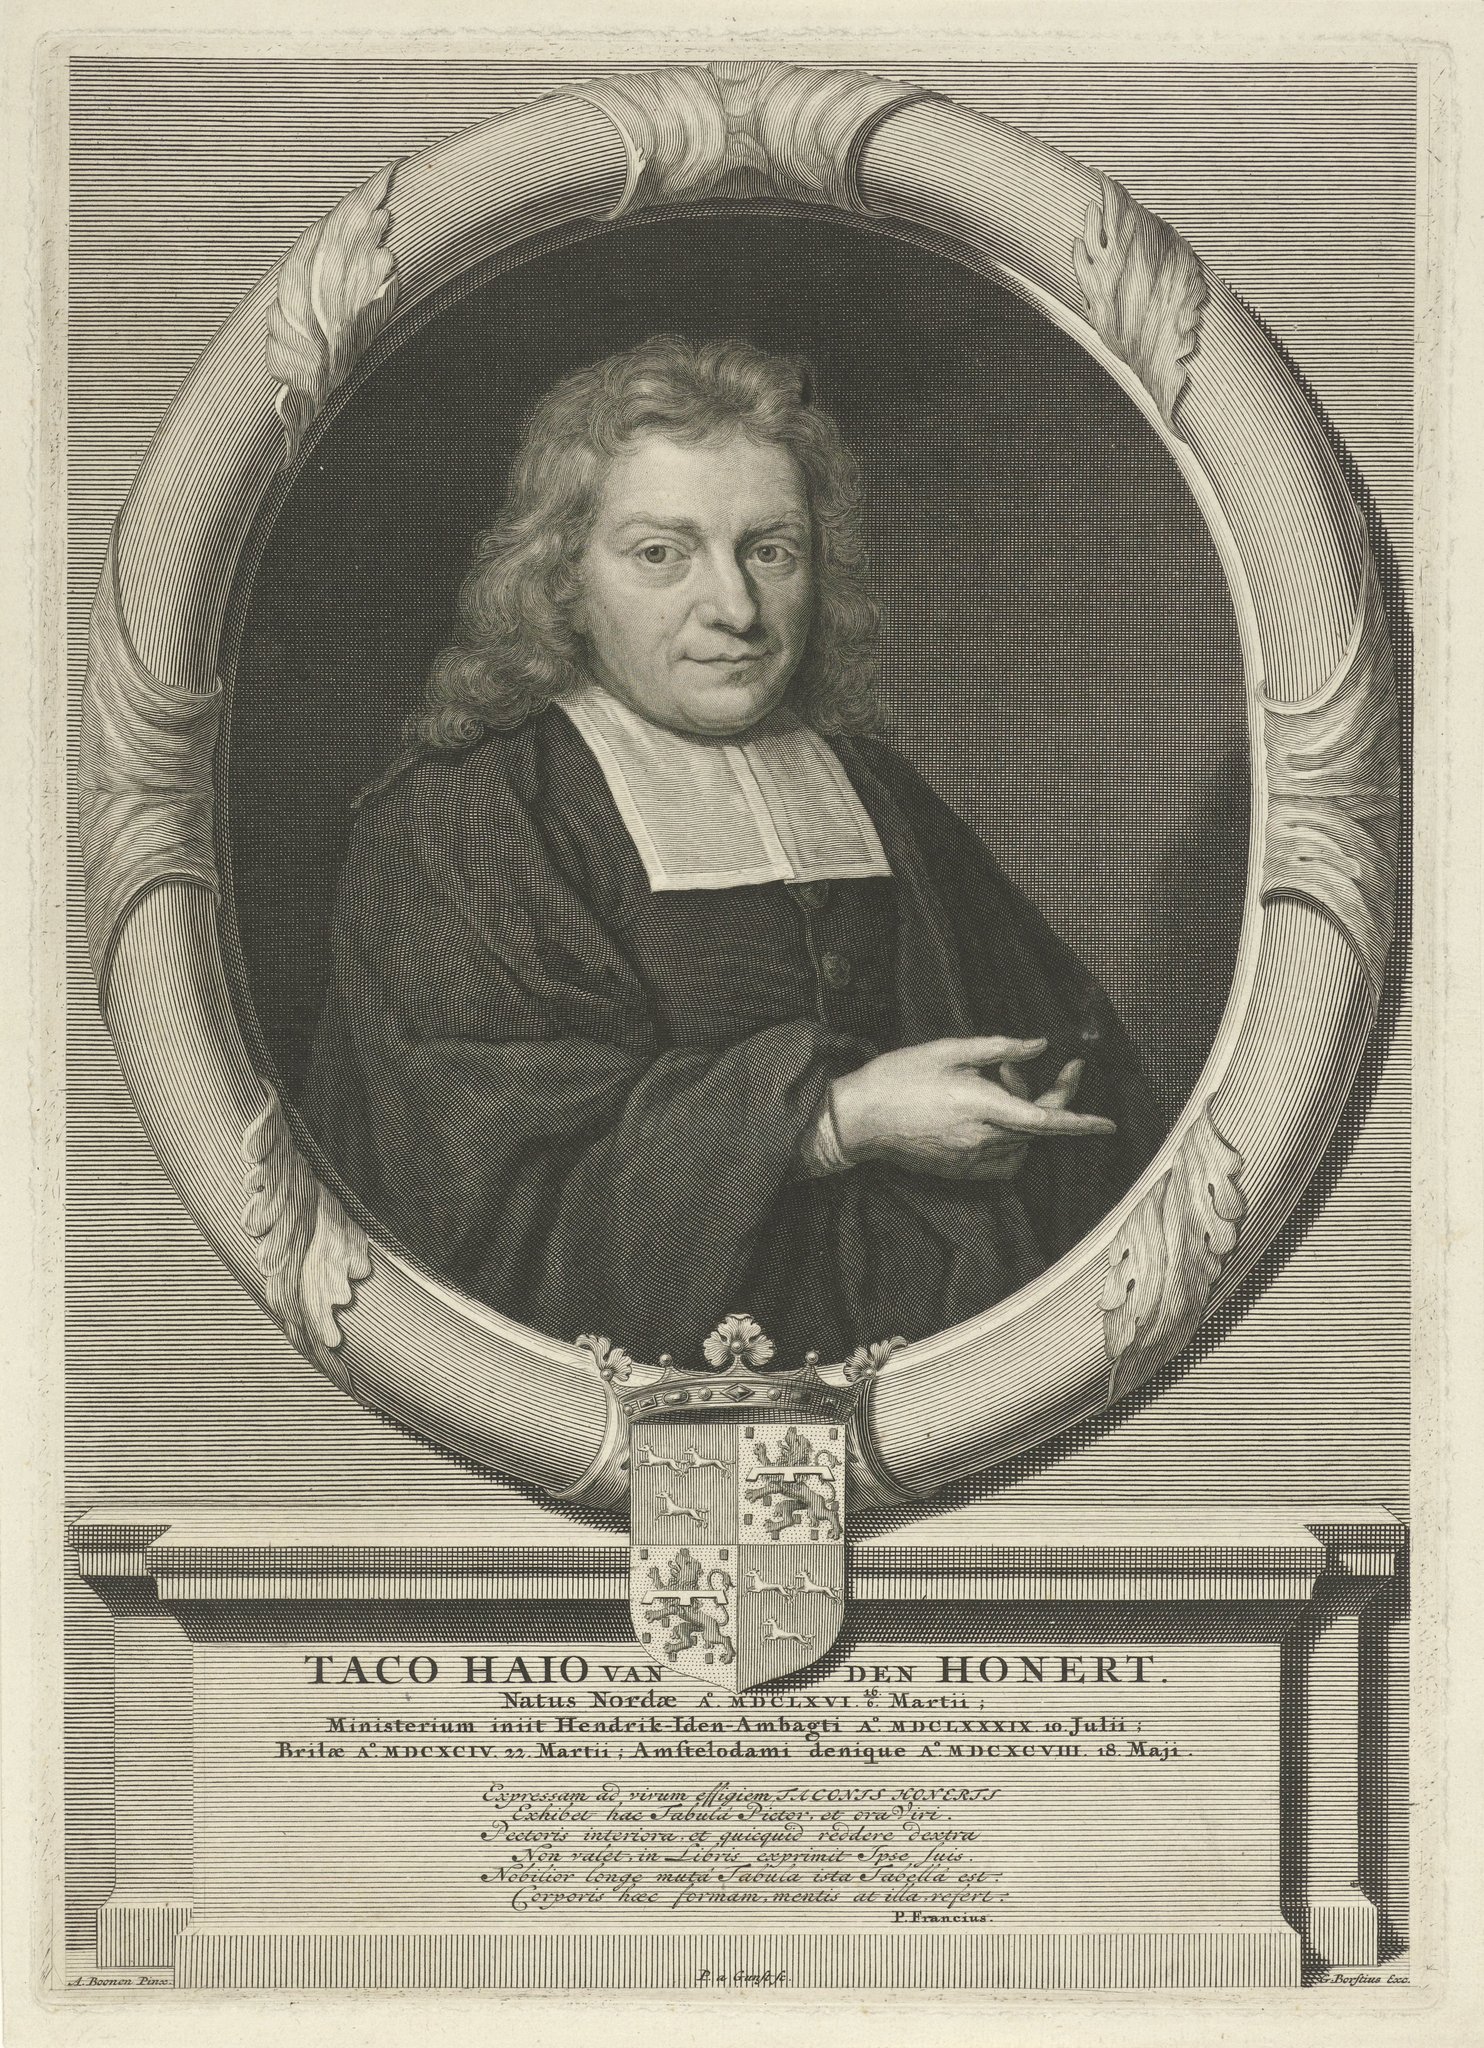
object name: print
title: Portret van Taco Hajo van den Honert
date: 1698-1707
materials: paper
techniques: engraving, etching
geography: amsterdam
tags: leiden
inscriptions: collector's mark: Lugt 2228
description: Taco Hajo van den Honert, Nederlands predikant en hoogleraar theologie te Leiden. Onder de prent zijn wapenschild en een Latijns onderschrift over zijn leven.